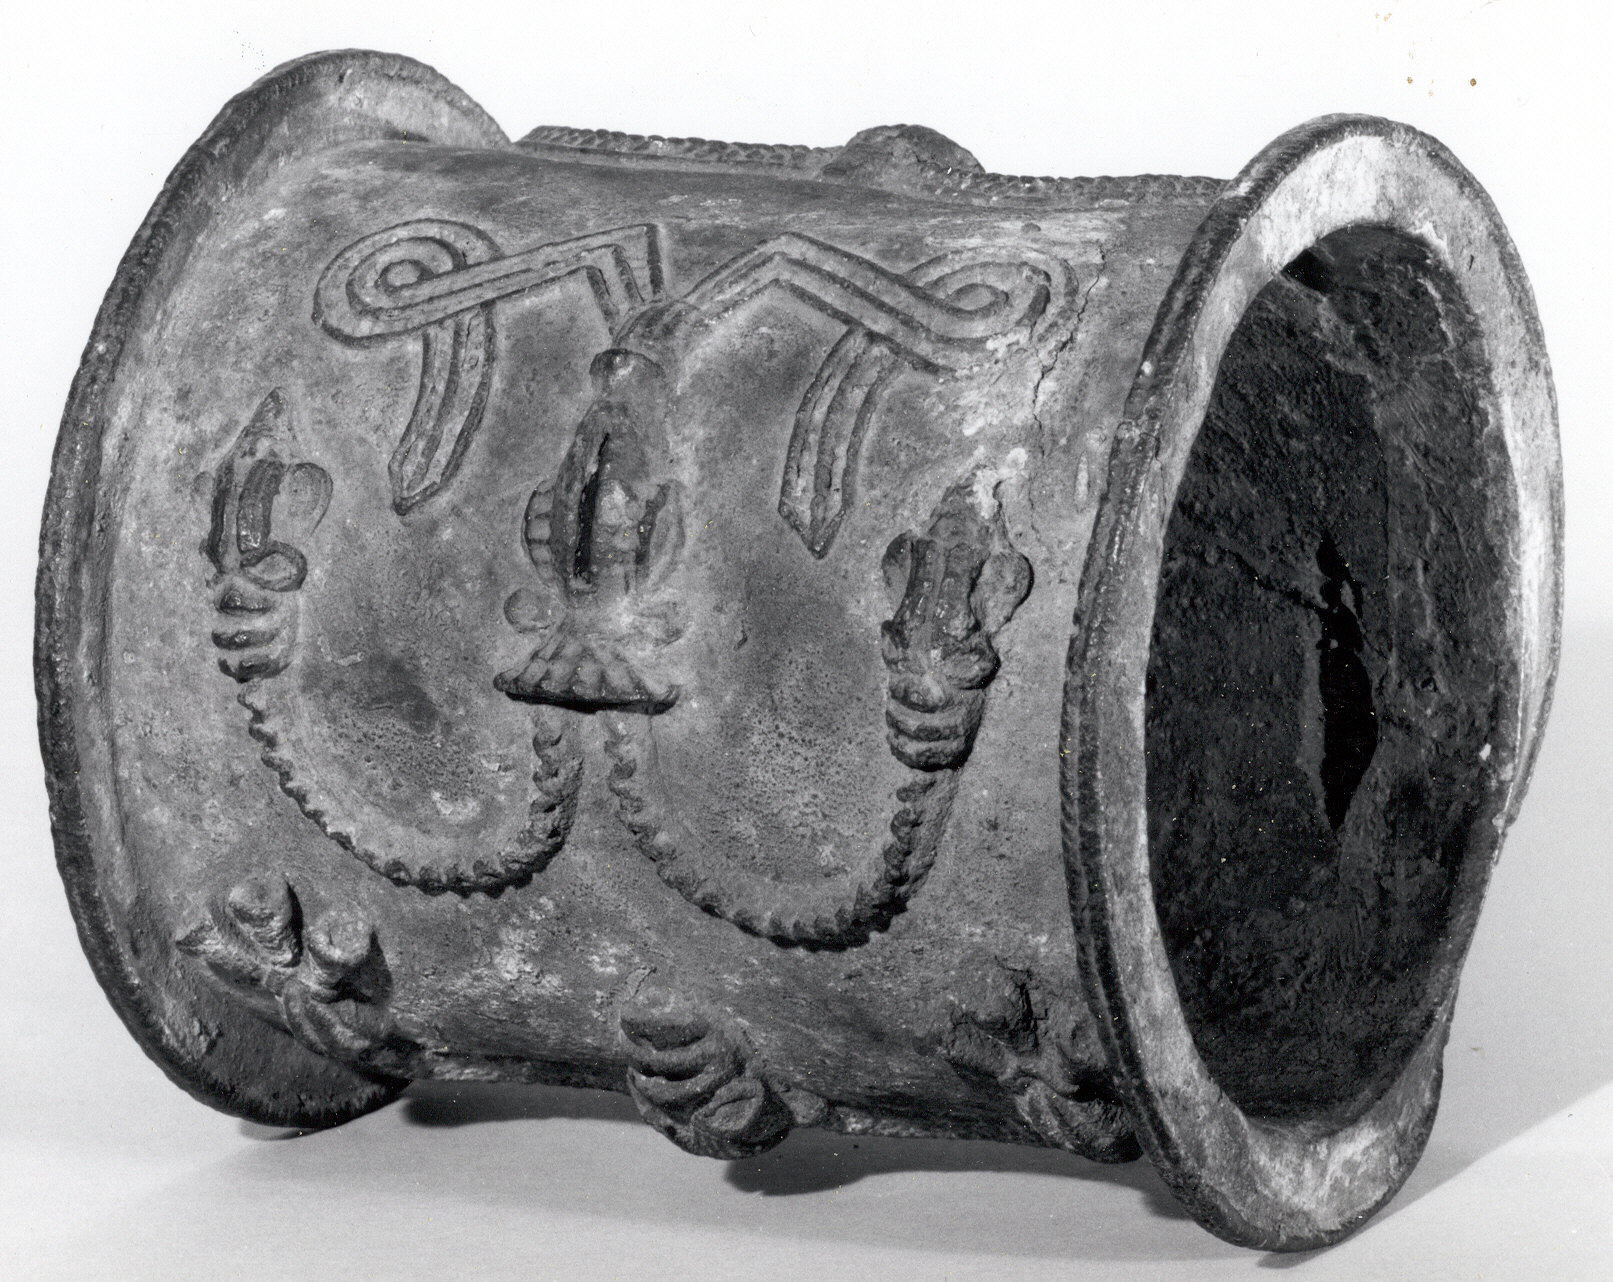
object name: armband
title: Arm Band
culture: yoruba peoples, ijebu group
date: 1701-1900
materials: brass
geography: nigeria